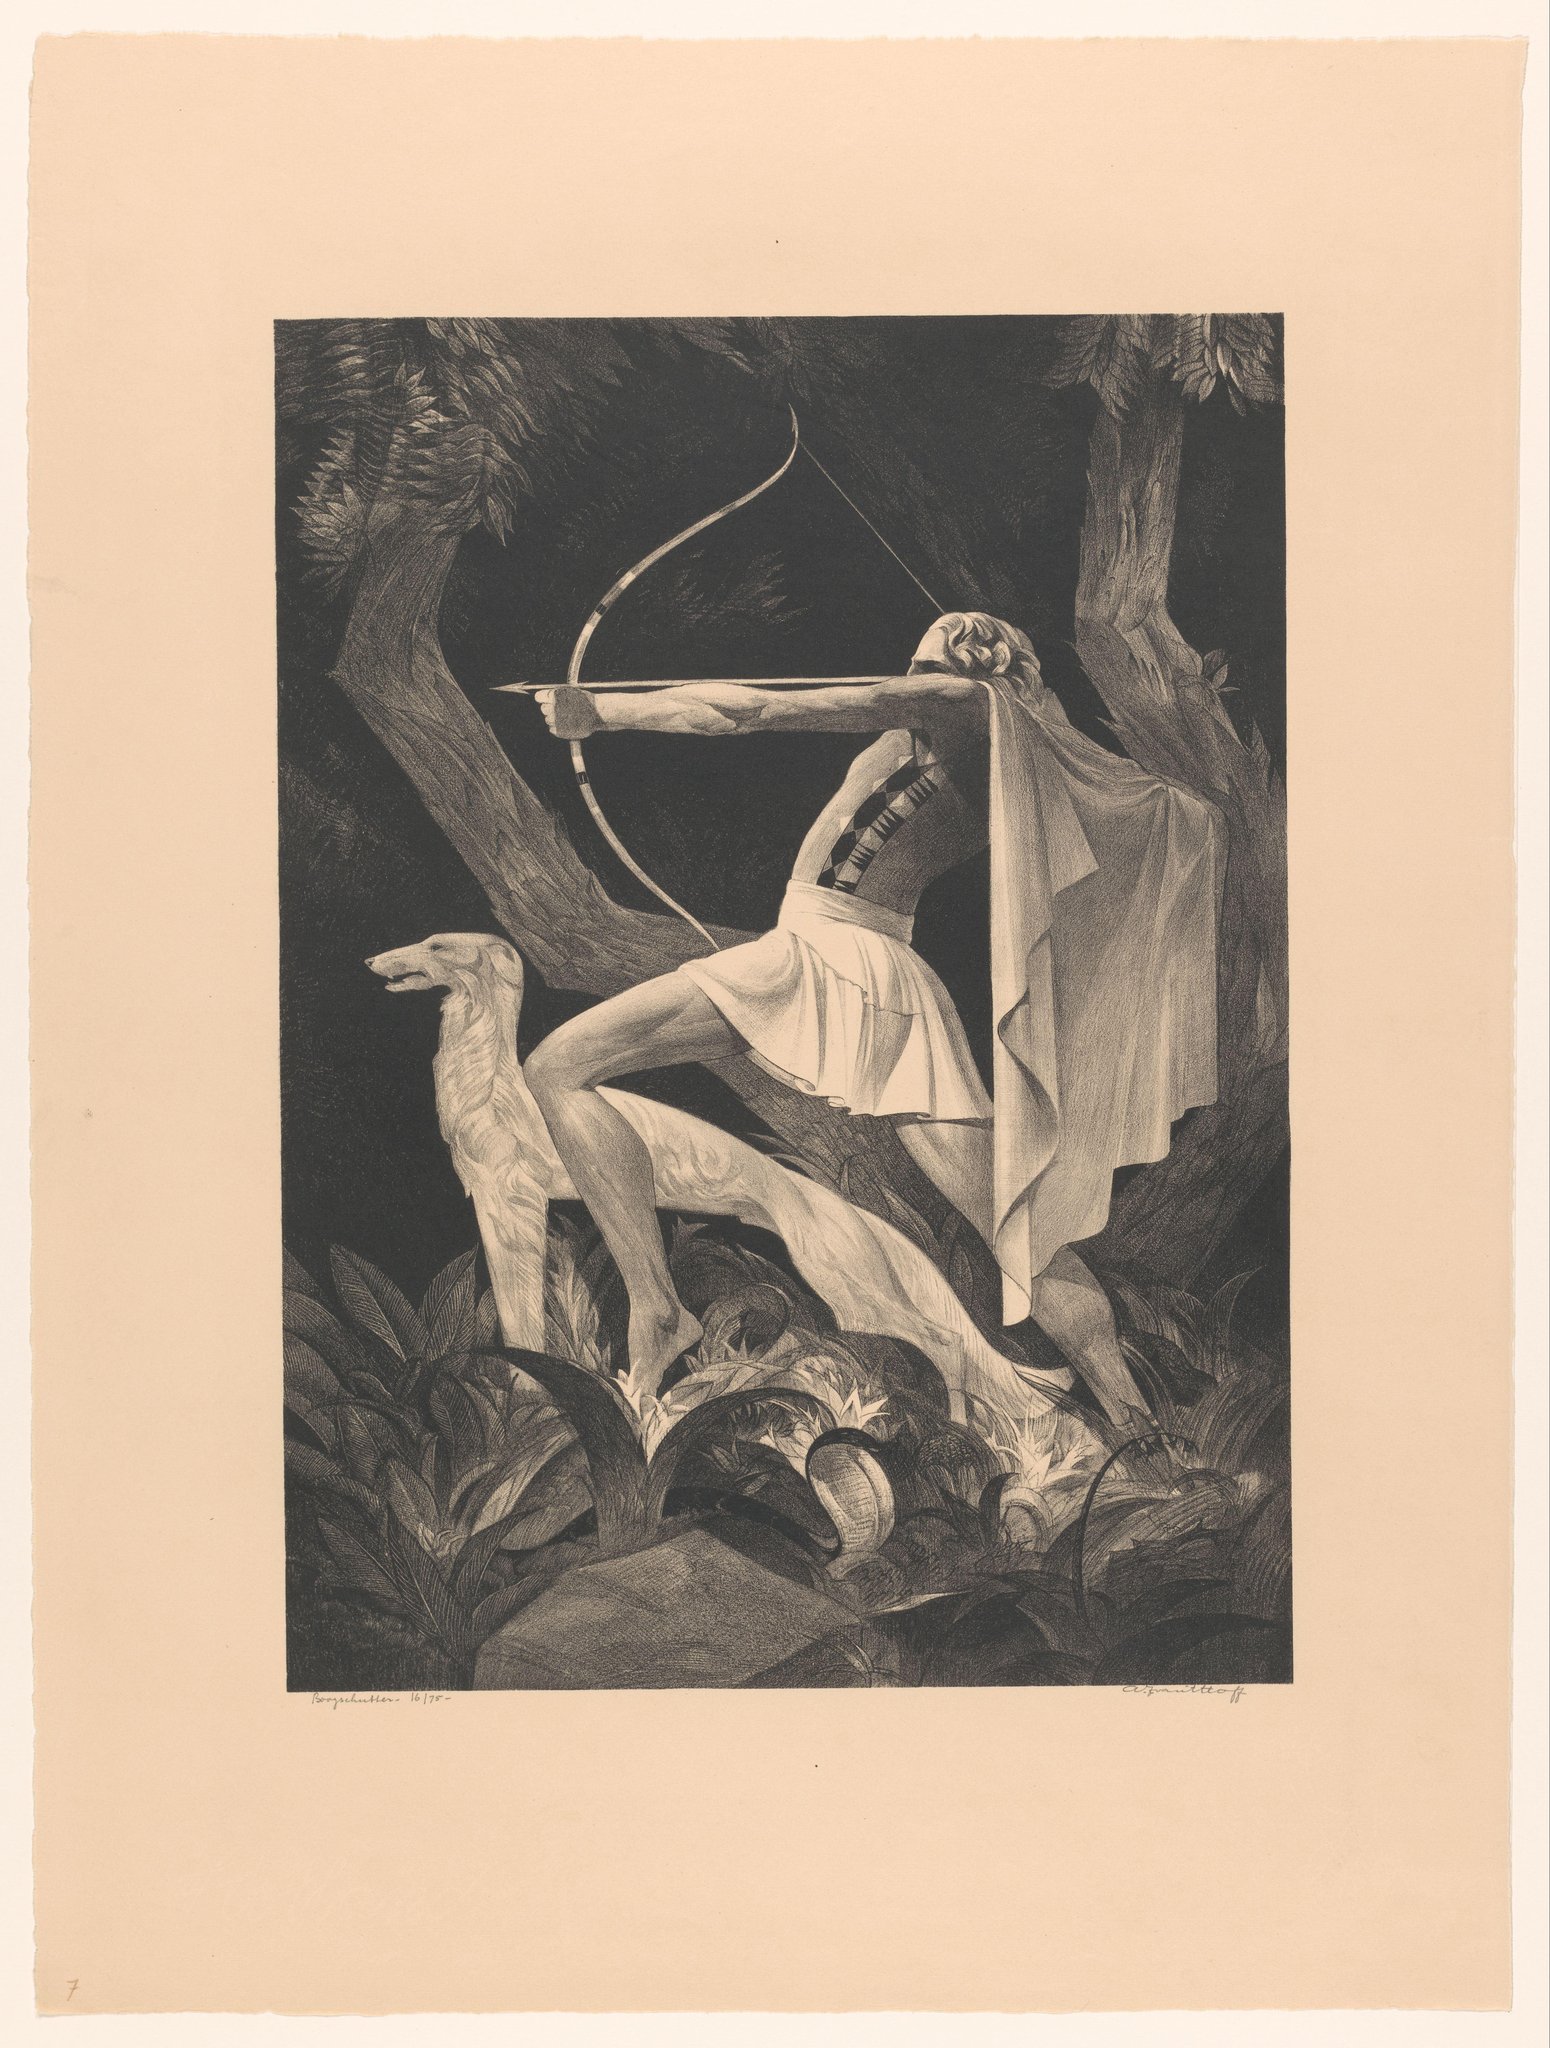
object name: print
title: Boogschutter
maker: adriaan j. van t hoff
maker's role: draughtsman, print maker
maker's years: 1893-1939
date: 1903-1932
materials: paper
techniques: lithograph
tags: archer's weapons, shooting with bow and arrow, archery (~ games of skill), dog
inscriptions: collector's mark: Lugt 2228